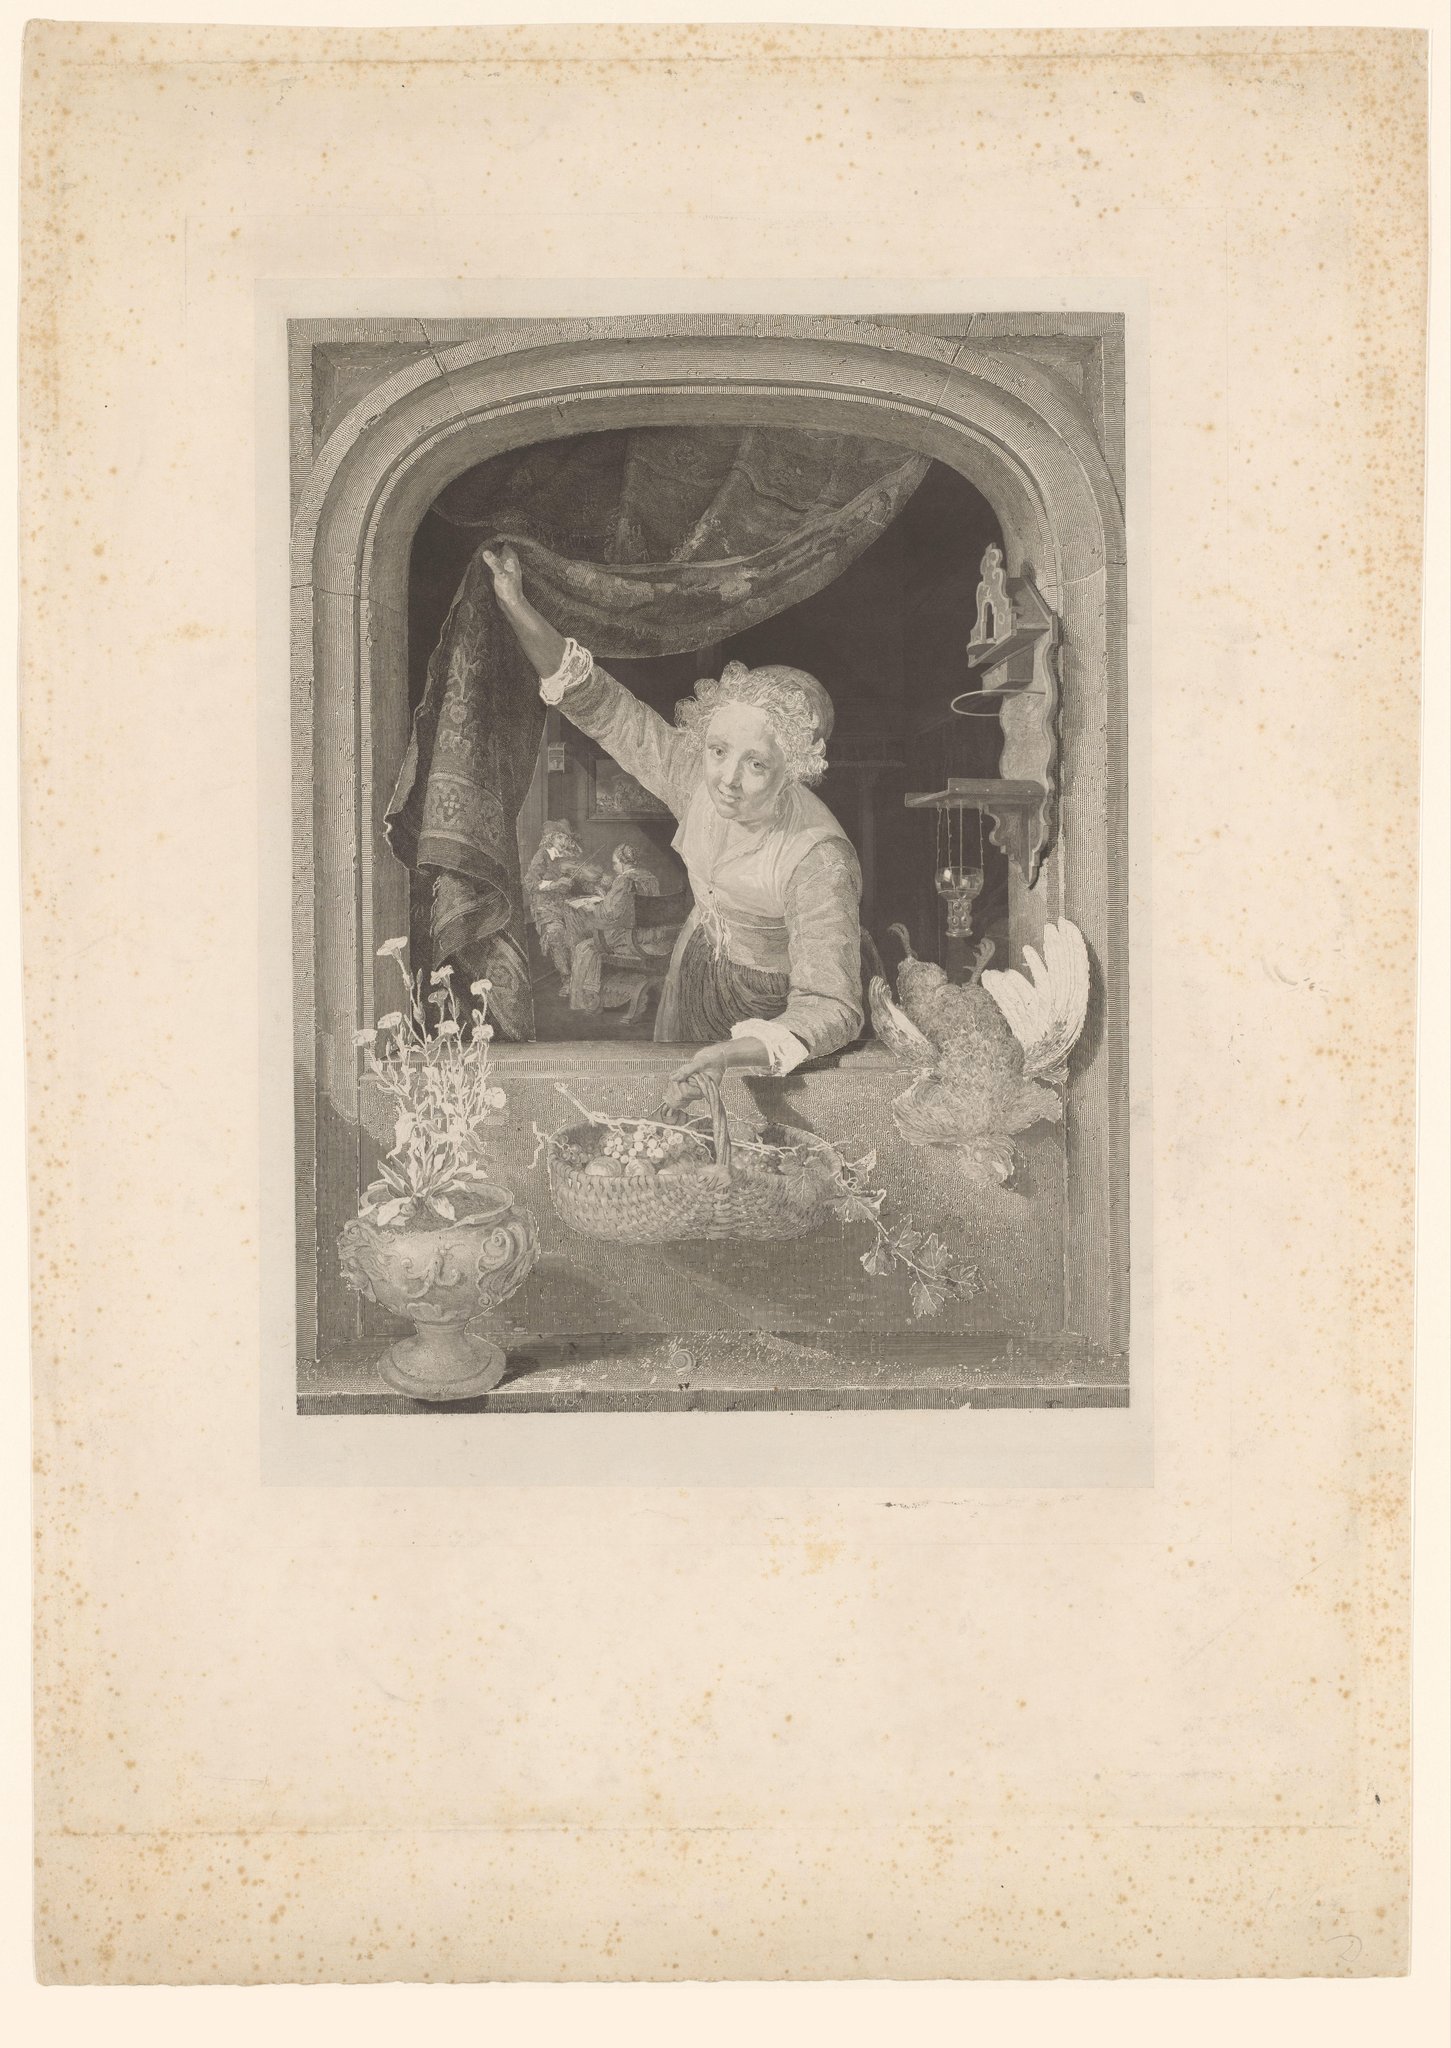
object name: print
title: Vrouw met mand met vruchten in de hand bij het raam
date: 1842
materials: paper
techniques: etching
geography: amsterdam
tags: instrumental and vocal music together, violin, fiddle, human figure at (open) window, seen from outside, fowl (cock, hen, chicken, etc.), fruits, shop-window, show-window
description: Een jonge vrouw met een mand met vruchten in de hand hangt uit een venster. Ze houdt het gordijn opzij zodat het interieur achter haar zichtbaar is. In het vertrek zijn een man en een vrouw aan het musiceren. In de vensterbank hangt een vogelhuis, ligt een dode haan en staat een vaas met bloemen.